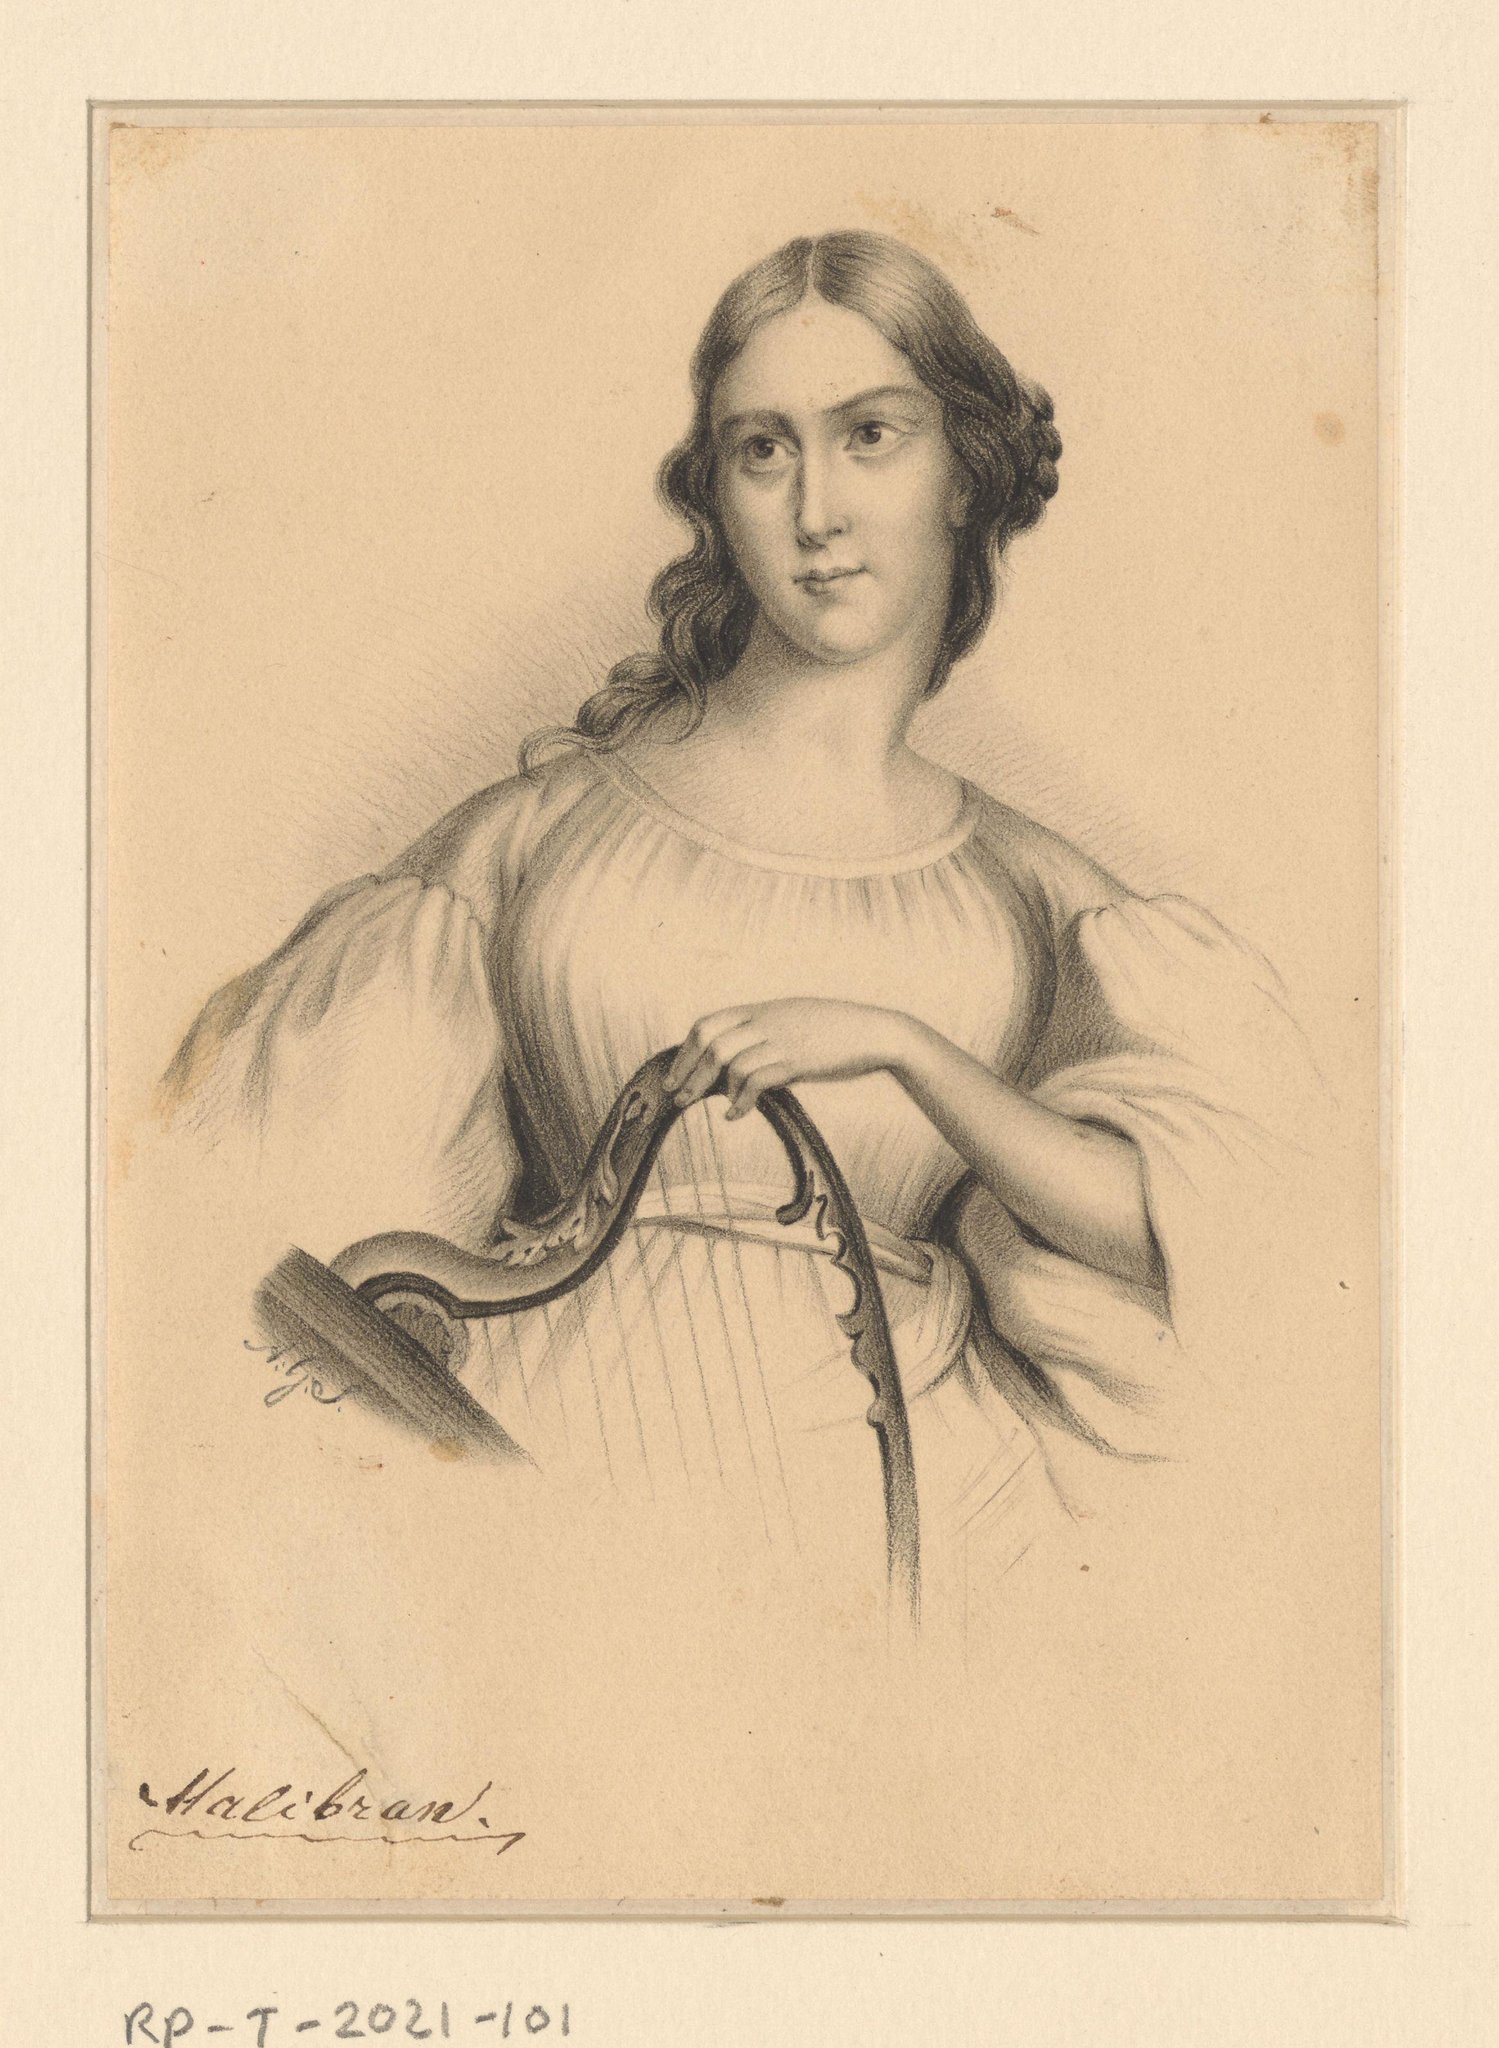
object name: drawing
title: Portret van Maria Malibran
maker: Anonymous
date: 1828-1880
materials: chalk, paper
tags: historical persons - bb - woman, harp, portrait of opera-singer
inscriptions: monogram: ‘A.G.S.’, inscription: ‘Malibran’